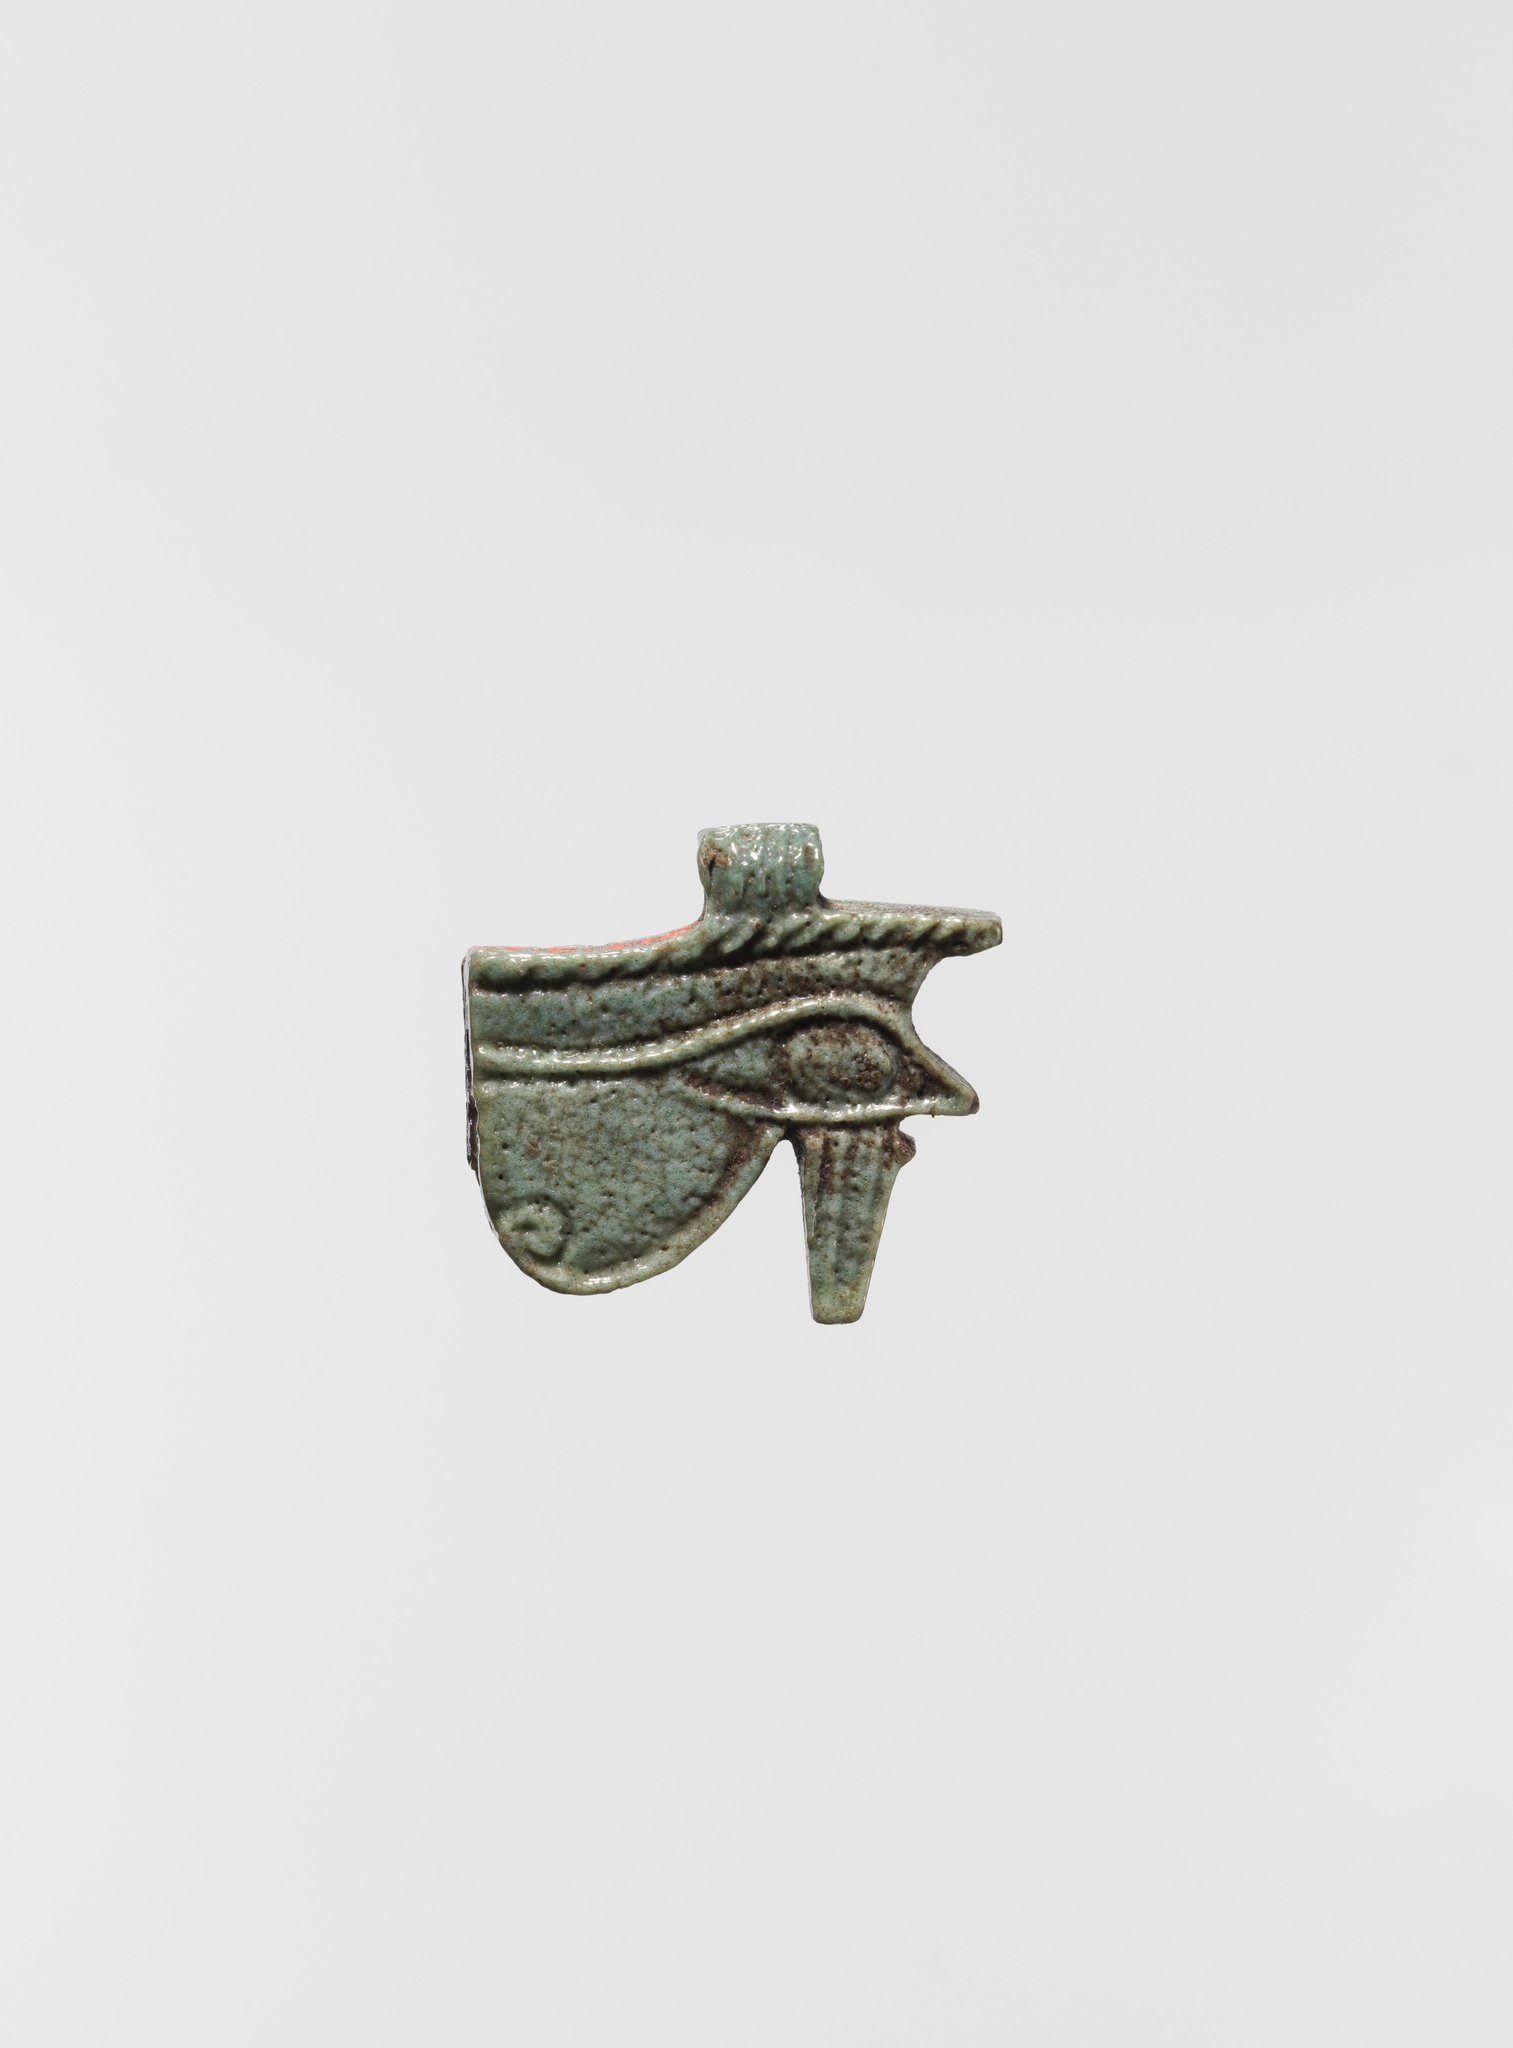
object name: amulet, wedjat eye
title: Wedjat Eye Amulet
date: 664-332 BCE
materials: faience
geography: egypt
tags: eyes